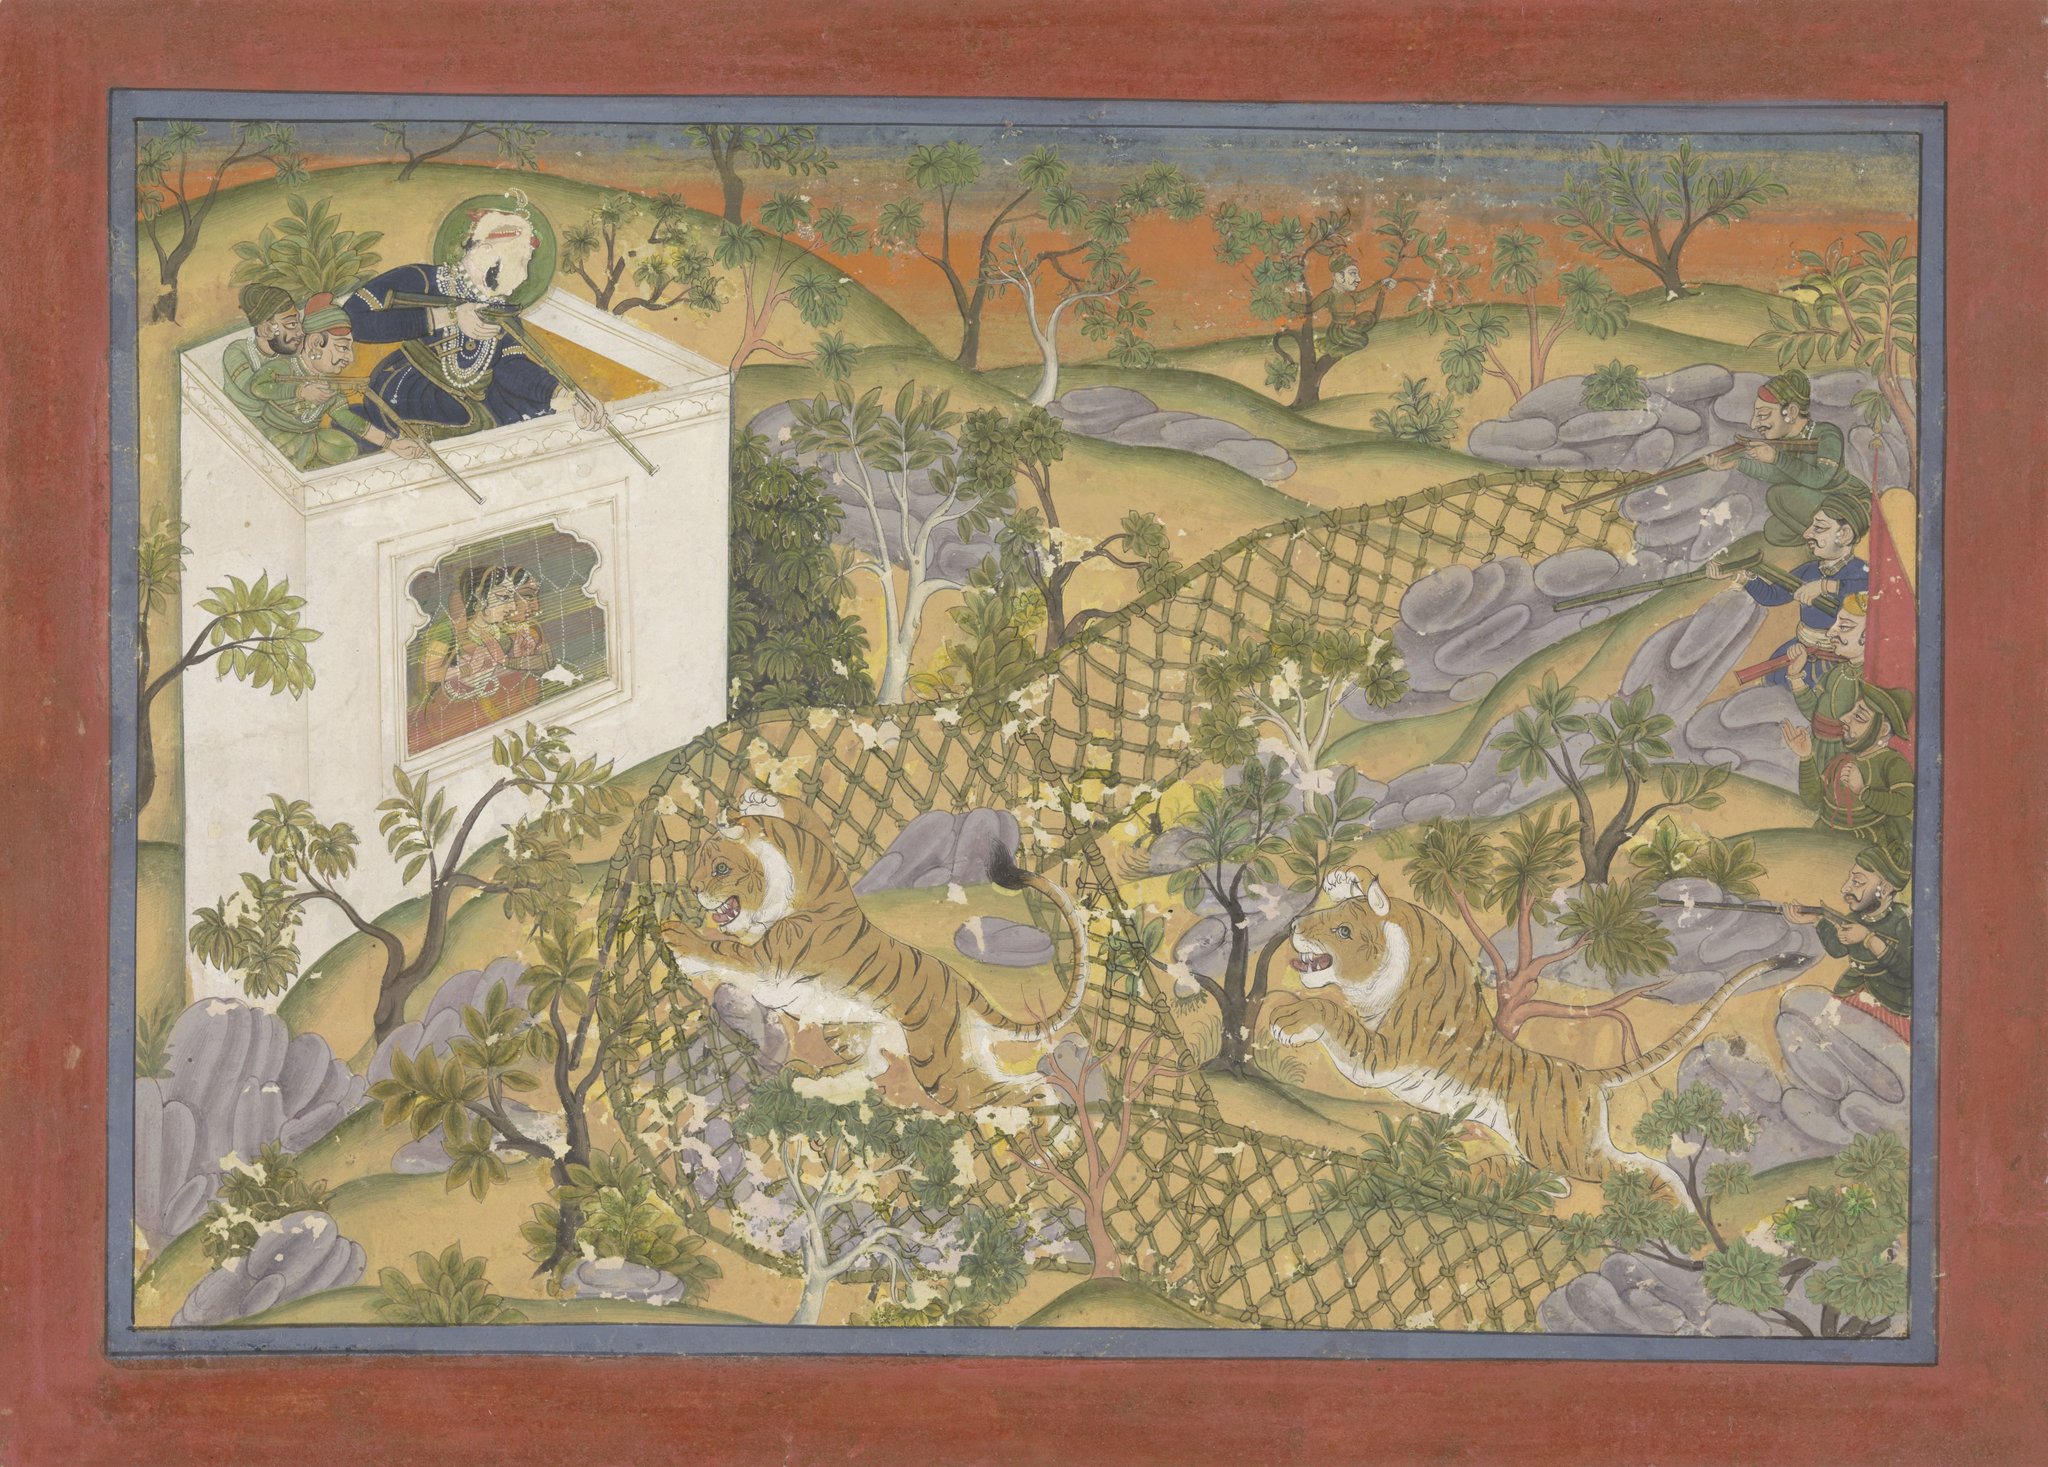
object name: indian miniature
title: Tijgerjacht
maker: Anonymous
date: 1830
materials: paper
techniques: brush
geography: kotah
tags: hunt ~ predatory animals (fox, lion)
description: Een wit paviljoen in een heuvellandschap met ondergaande zon; op het dak van het paviljoen twee mannen met geweren en een derde man die half zichtbaar is, voor het raam beneden twee dames die toekijken, achter een groot vangnet dwars door de voorstelling twee bloeddorstige tijgers en wat jagers achter de rotspartijen. De voorstelling is omlijst door een grijze bies in zwarte kaderlijnen en een brede rode rand.